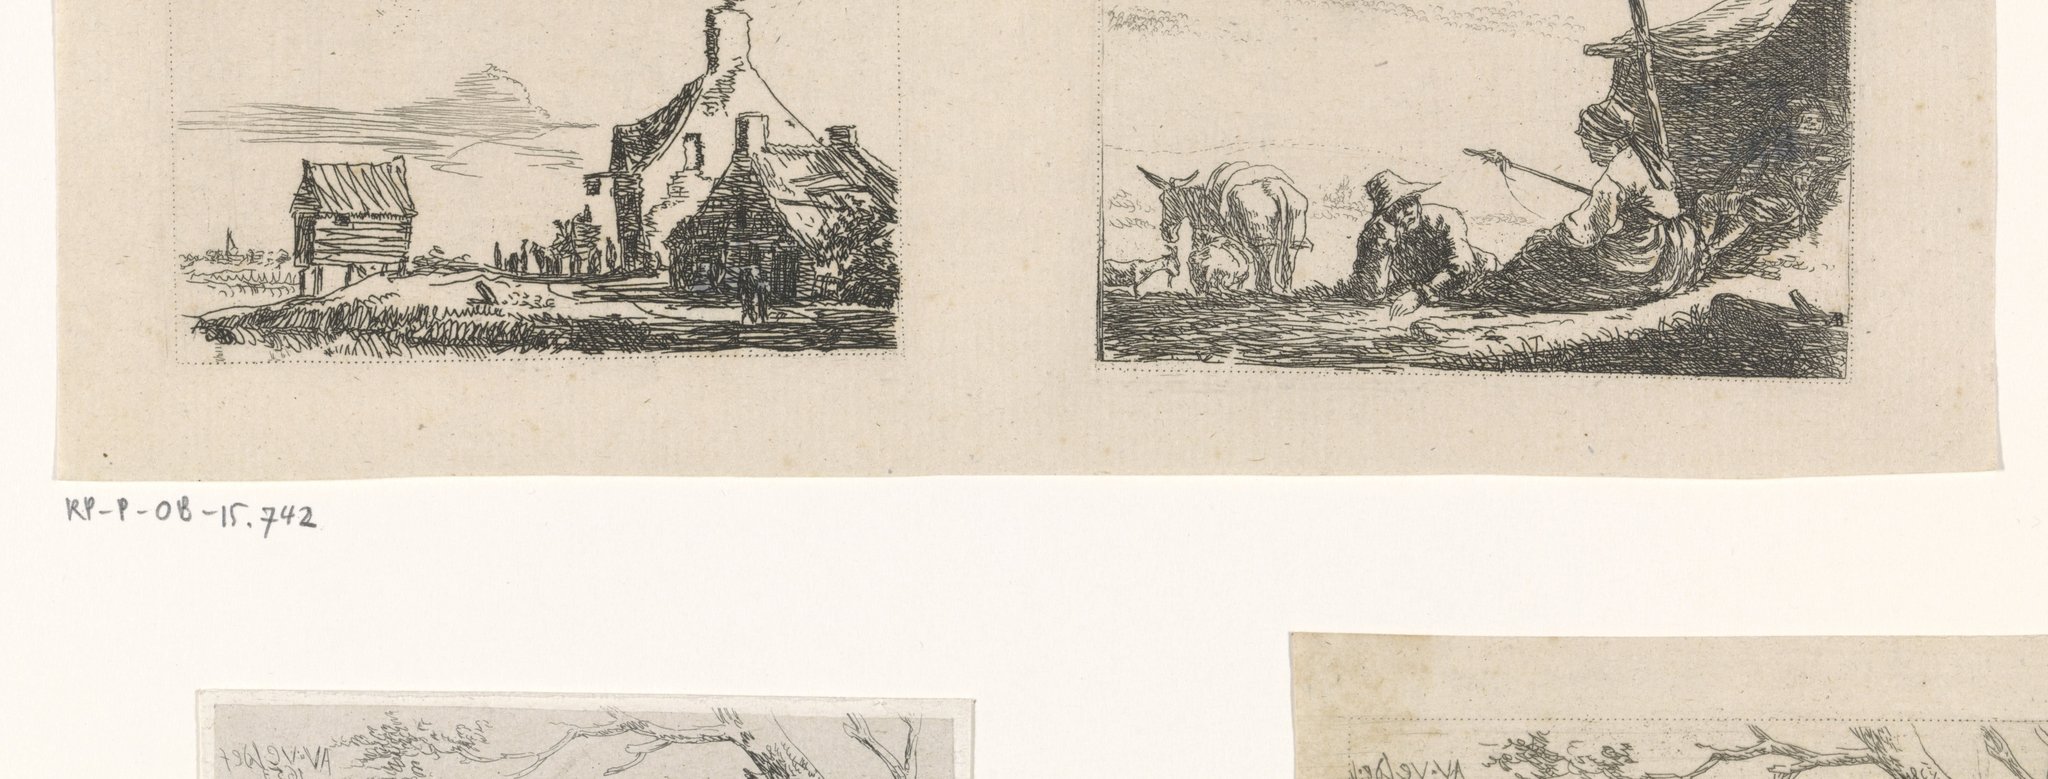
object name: print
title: Landschap met een wagen bij een herberg/ Figuren bij een tent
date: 1653-1703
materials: paper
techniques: drypoint, etching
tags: chimney, tent, ass, donkey, distaff, lying on one side, with uplifted upper part of the body and leaning on the arm, hotel, hostelry, inn, (farm) wagon, freight wagon, cart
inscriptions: collector's mark: Lugt 2166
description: Twee afbeeldingen op een blad. Links een landschap met een wagen bij een herberg. Rechts een zittende vrouw met een spinrok in de hand in gesprek met een liggende man, leunend op zijn elleboog, voor een tent. In de tent nog een derde figuur.